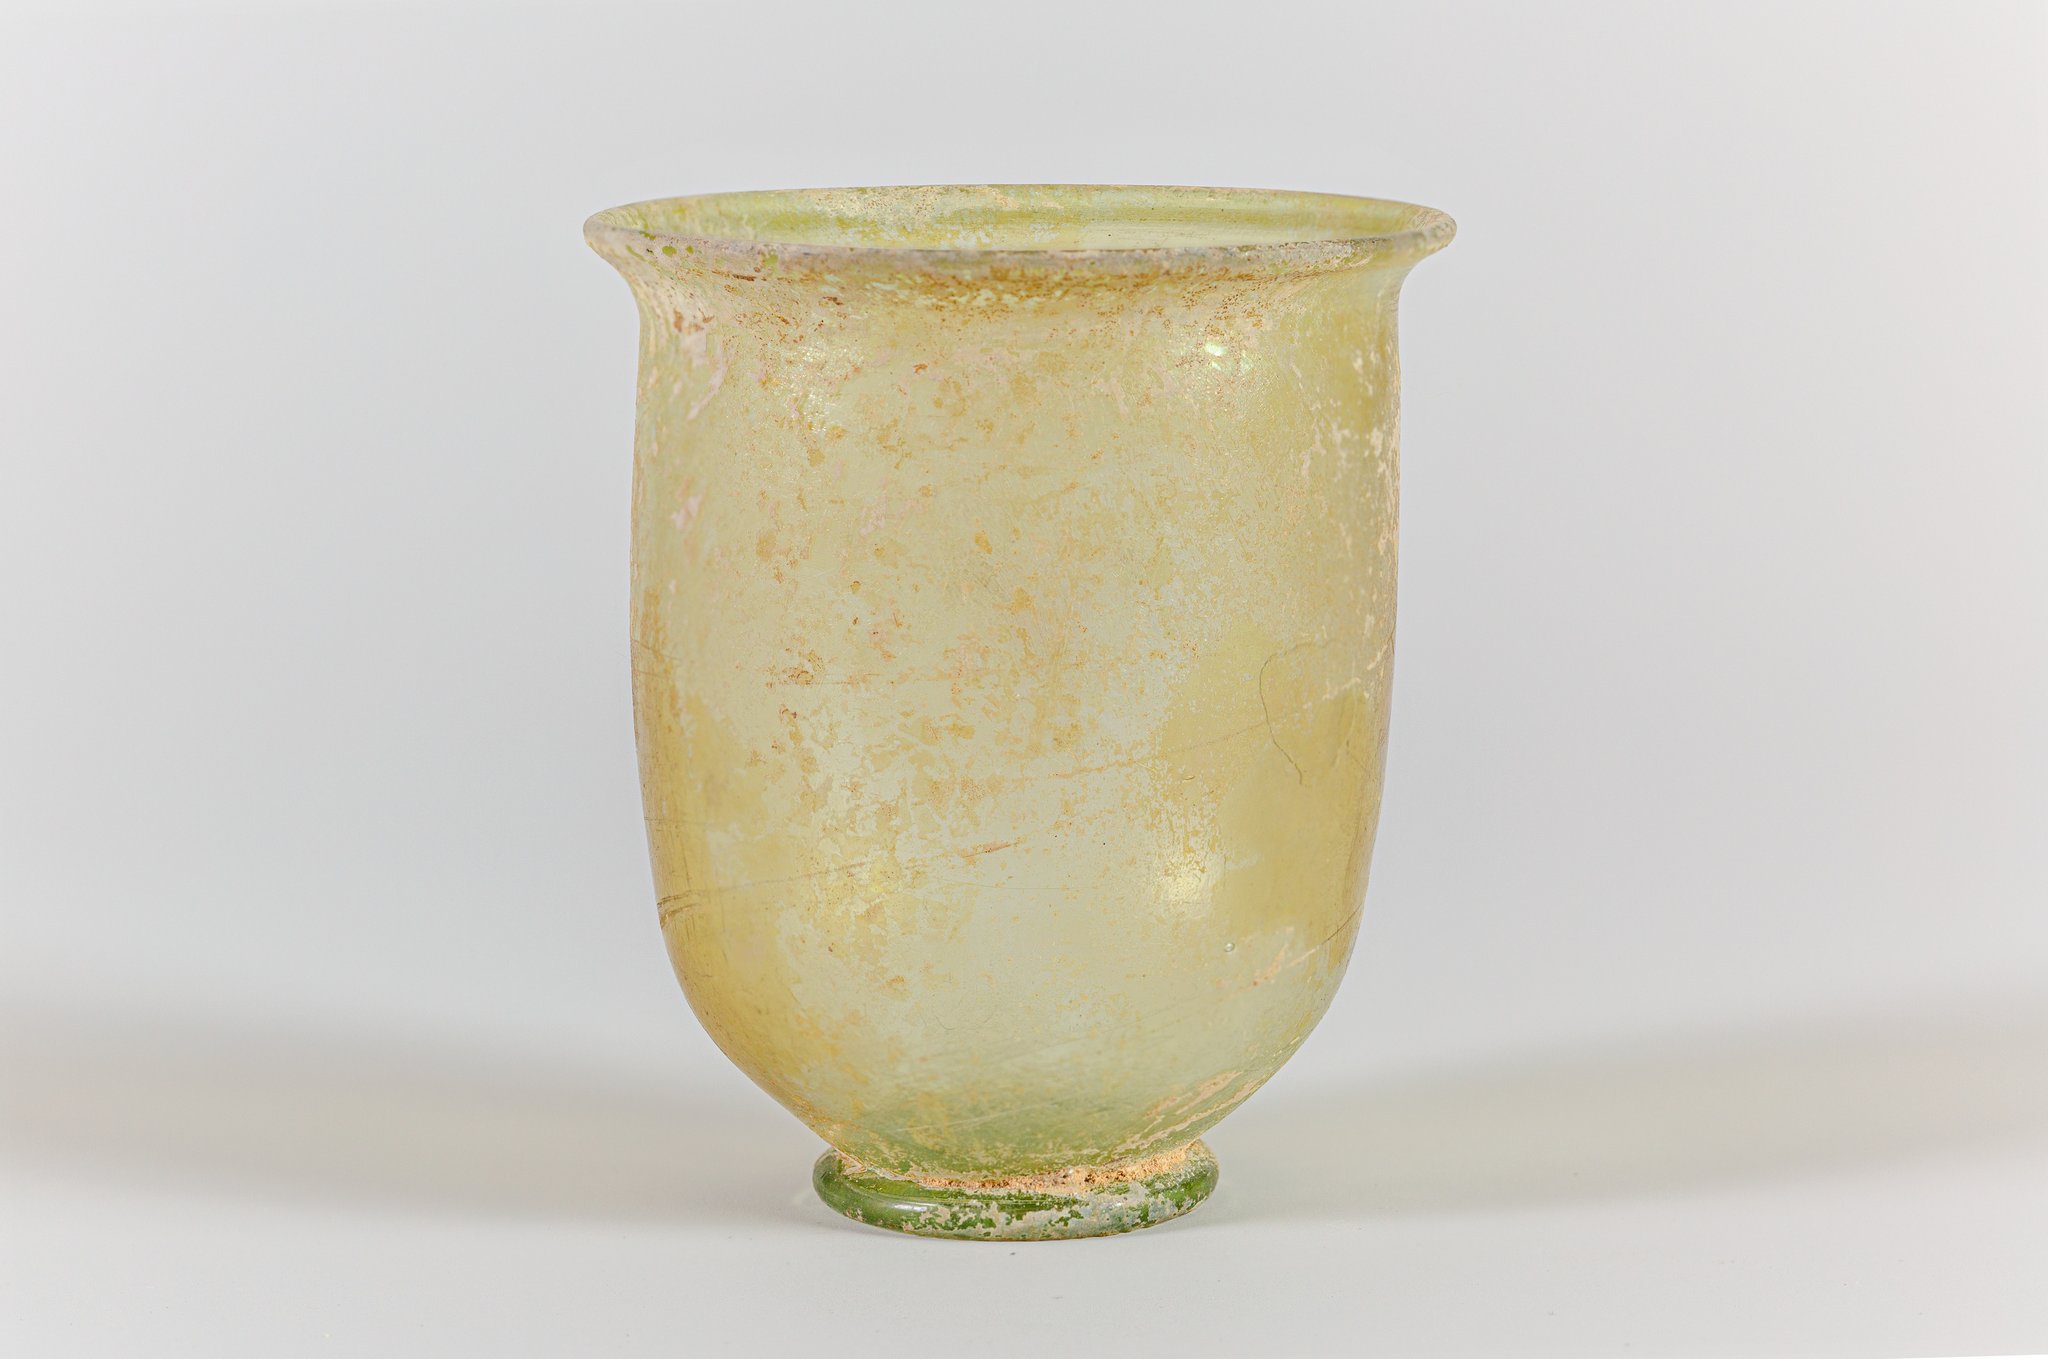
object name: beaker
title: Glass beaker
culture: roman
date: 201-400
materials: glass